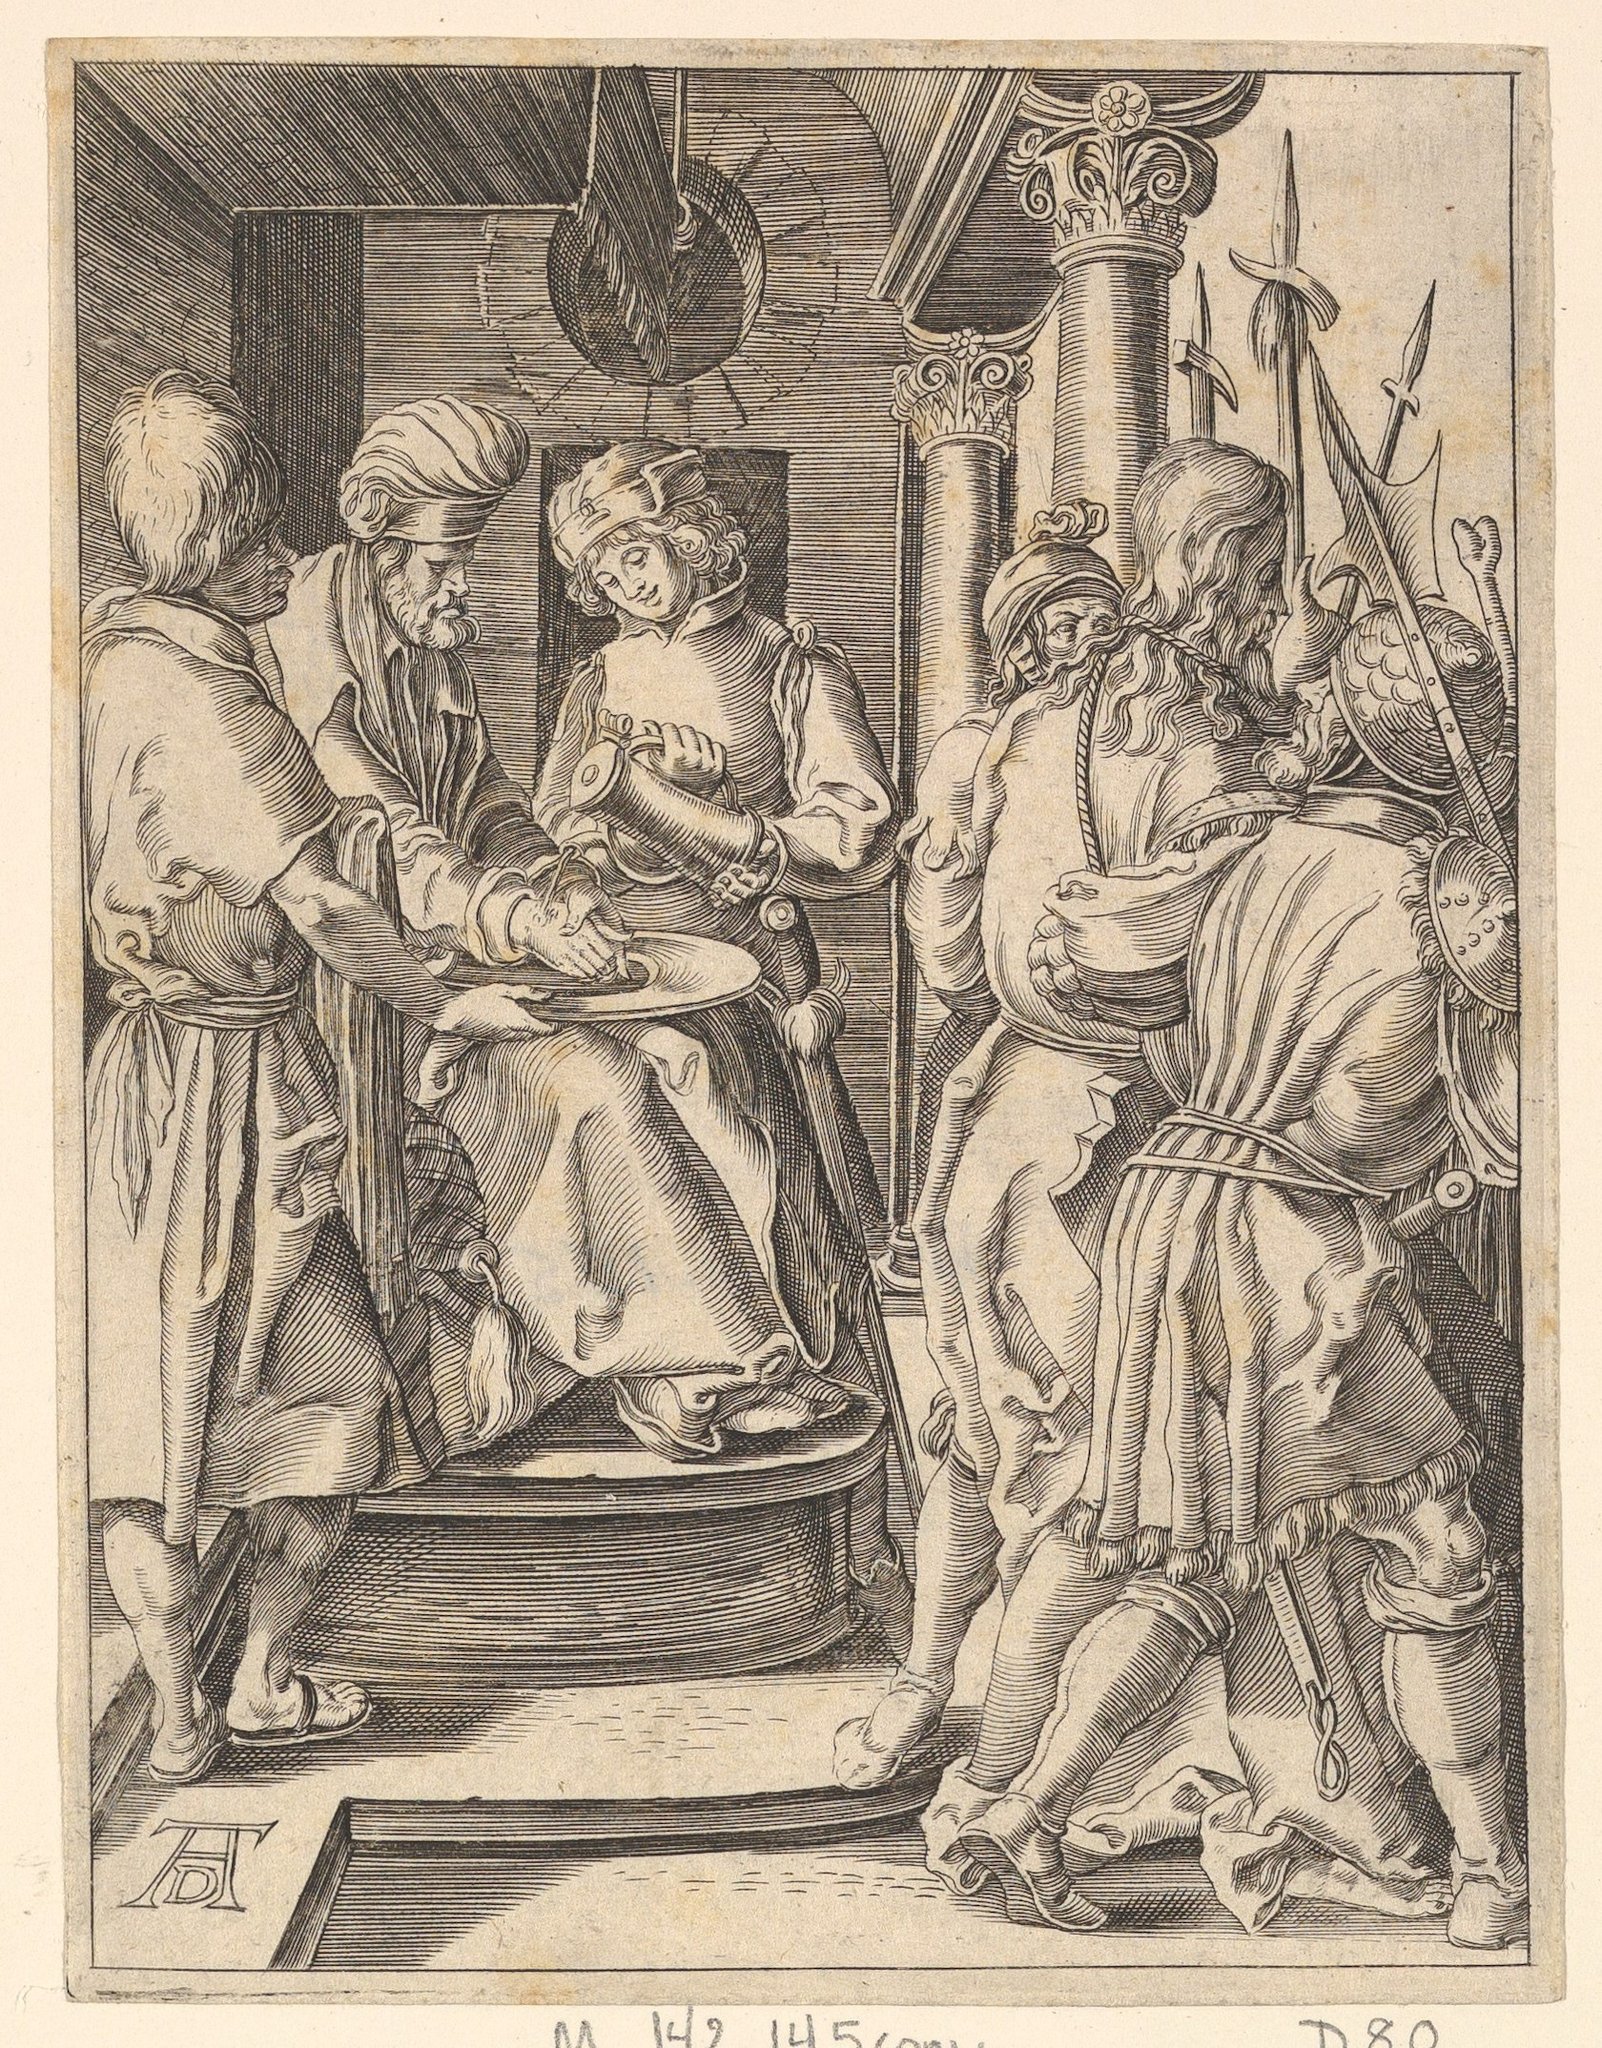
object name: print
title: Engraved copies of The Little Passion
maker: albrecht dürer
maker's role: artist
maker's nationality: german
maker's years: 1471-1528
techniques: engraving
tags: soldiers,men,women,christ,washing